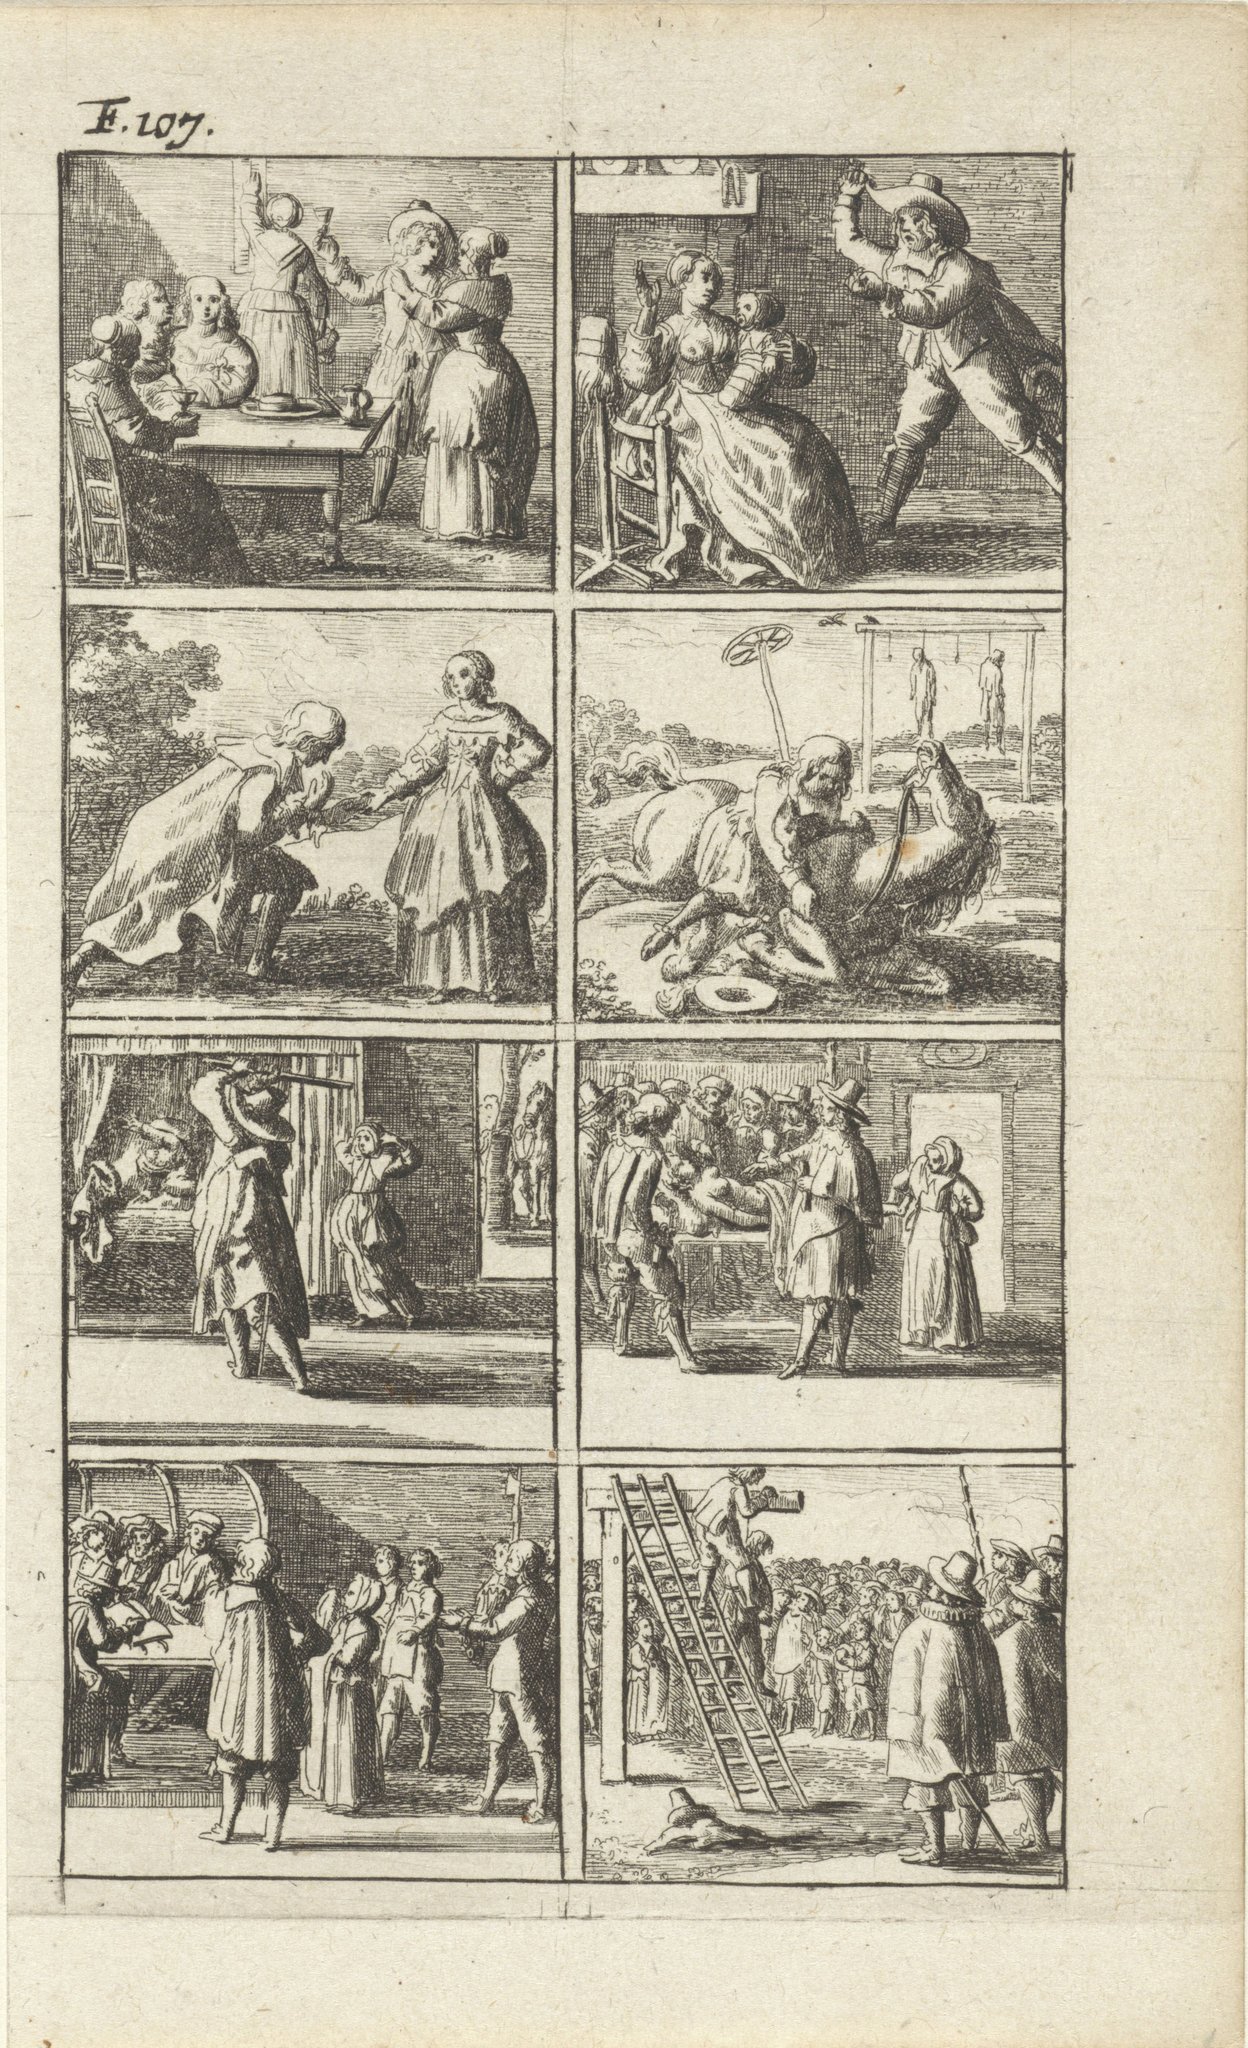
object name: print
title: Verhaal met voorstellingen van moord en doodstraf (F. 107.)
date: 1667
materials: paper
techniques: etching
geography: amsterdam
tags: death penalty, execution, murder, fighting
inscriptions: collector's mark: Lugt 2760, collector's mark: Lugt 2166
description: Verhaal in acht scènes met enkele voorstellingen van moord en doodstraf. Onder andere van een man die van een paard valt, enkele mensen aan een galg en van een man die een vrouw in haar bed vermoordt. Linksboven: F. 107.